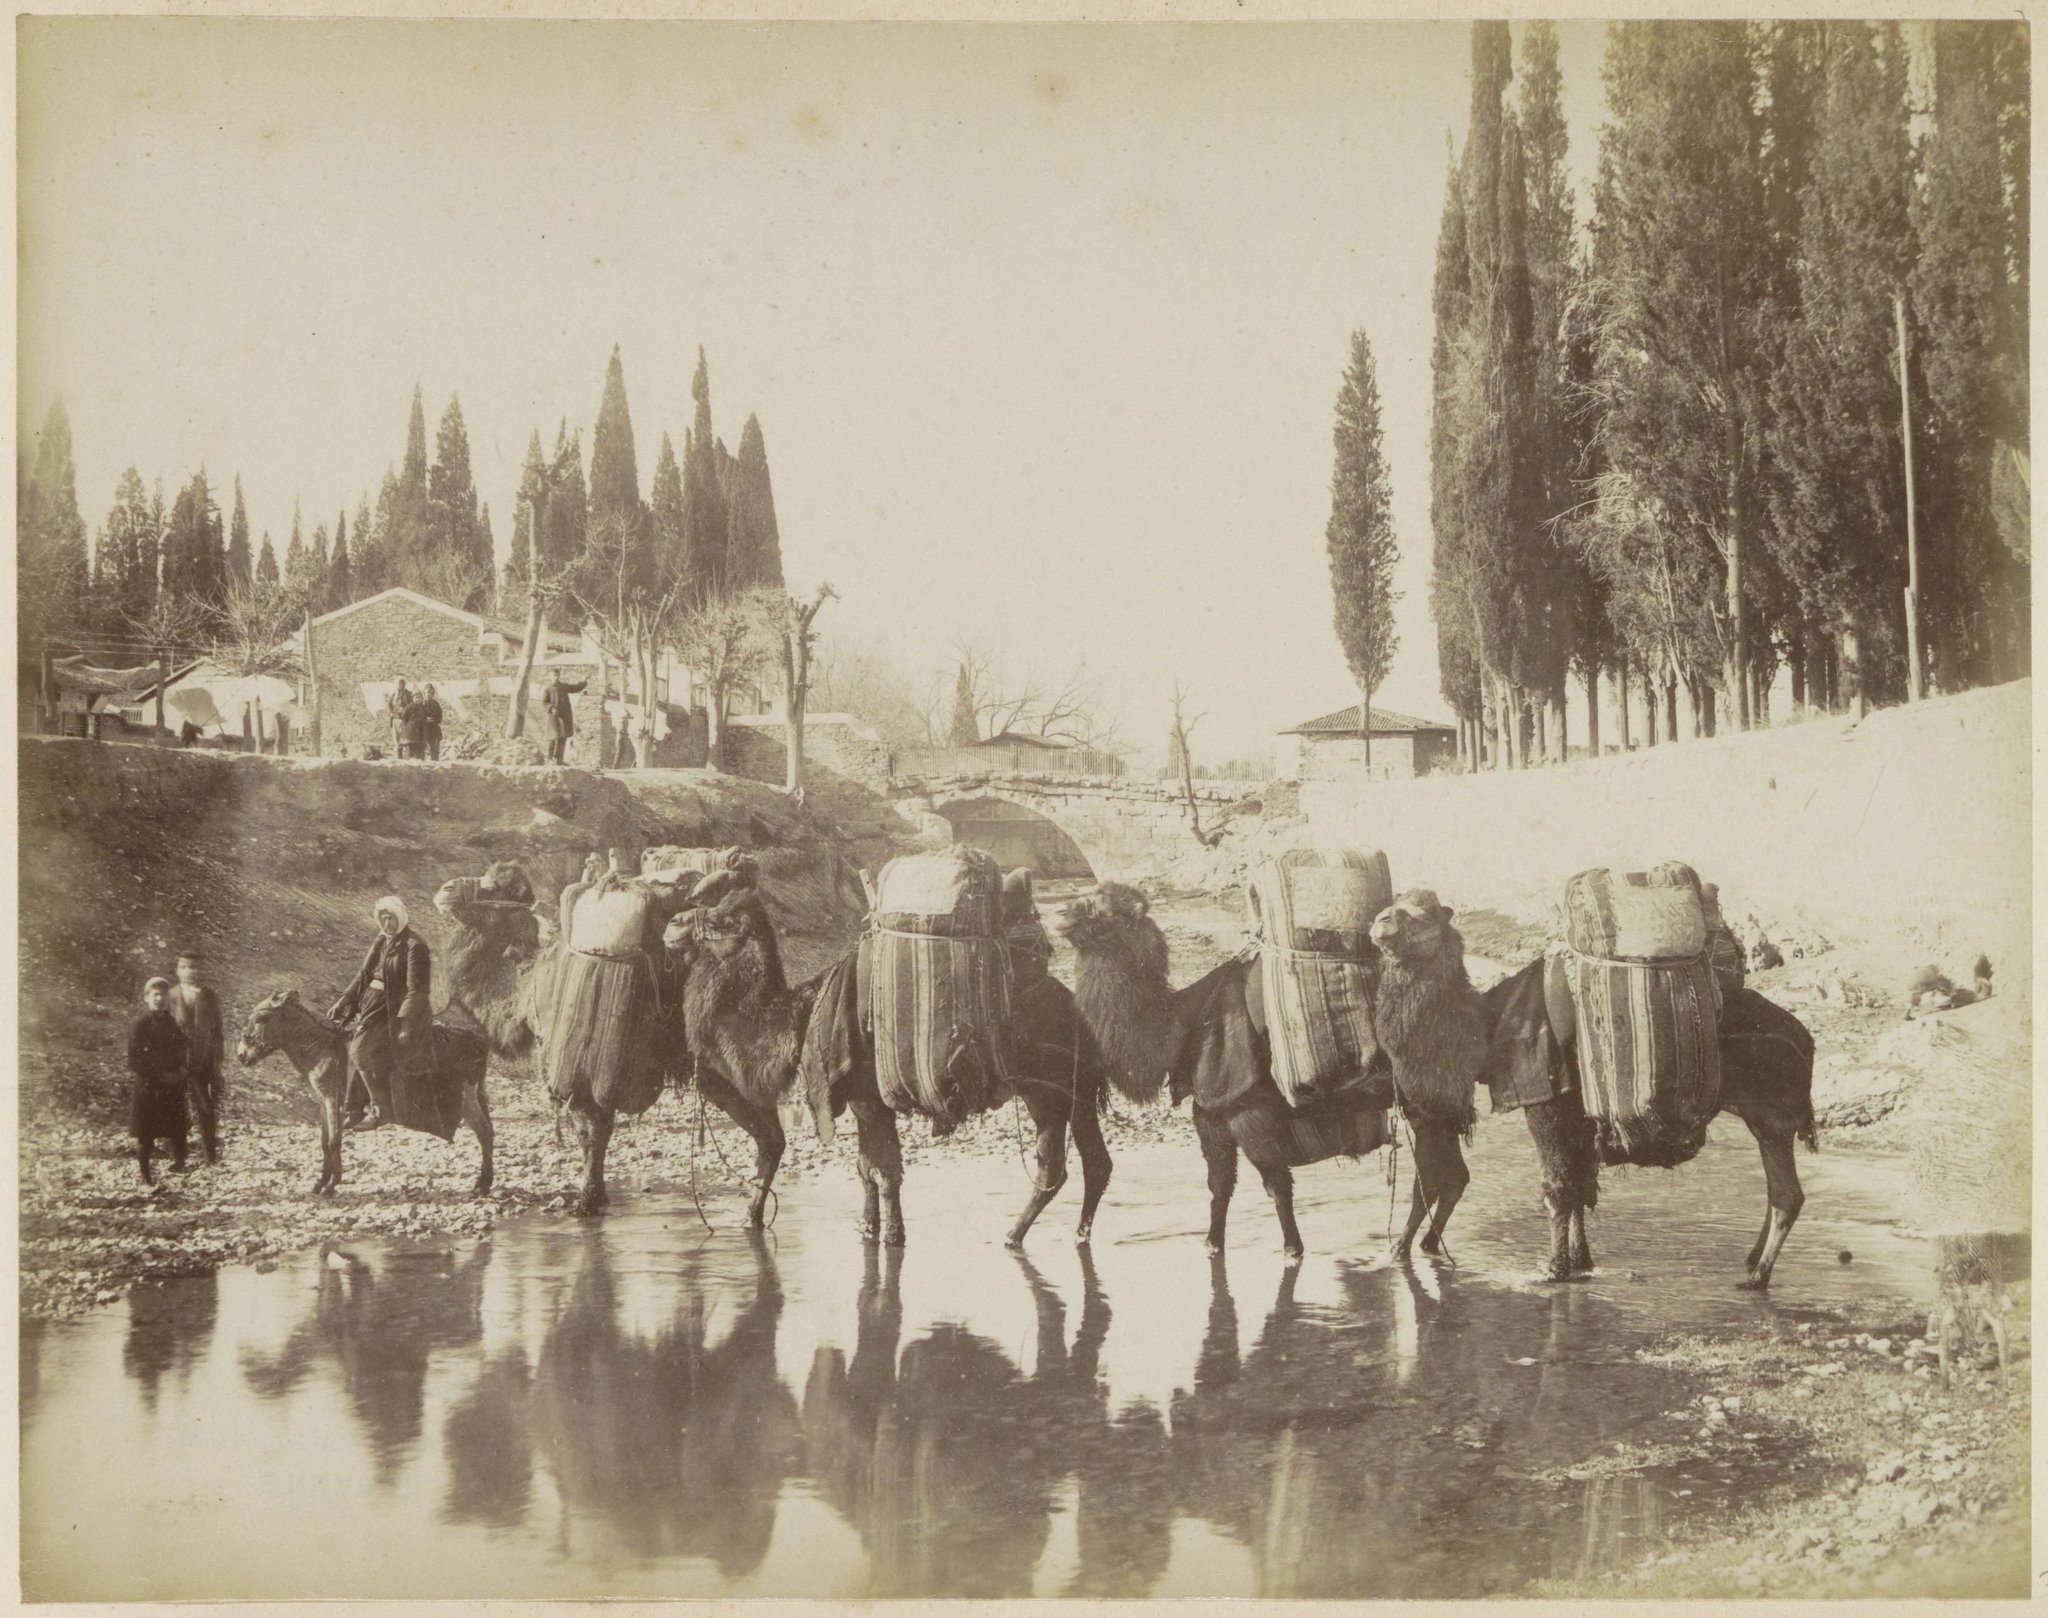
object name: photograph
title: Beladen lastdieren steken rivier over, vermoedelijk bij Smyrna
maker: Anonymous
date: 1880-1890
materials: paper, photographic support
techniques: albumen print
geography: turkey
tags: hoofed animals: camel, hoofed animals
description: Onderdeel van Reisalbum met foto's van bezienswaardigheden in Frankrijk, Griekenland en Turkije.